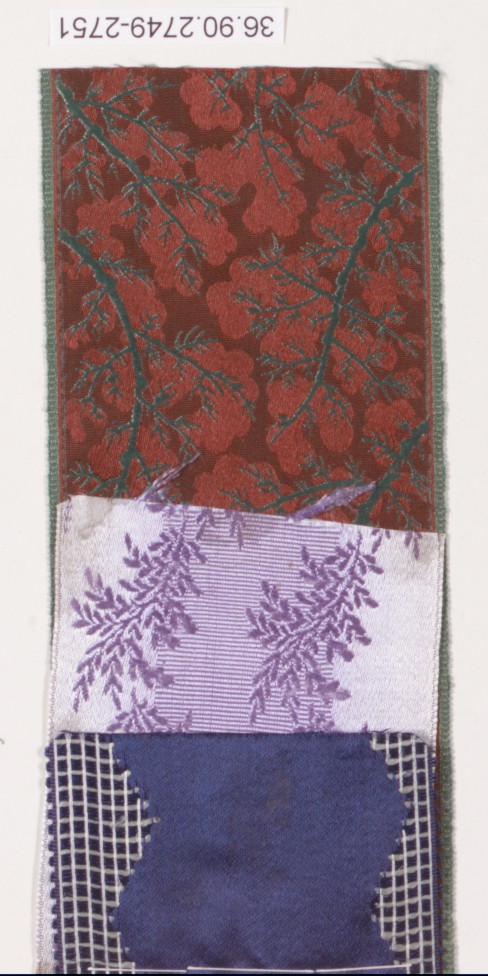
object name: ribbon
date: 1801-1900